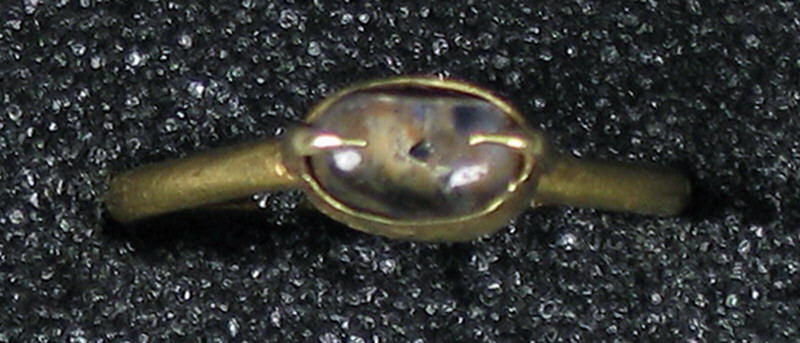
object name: ring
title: Ring with Round Bezel and Crystal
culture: indonesian, central java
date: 701-1200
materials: gold